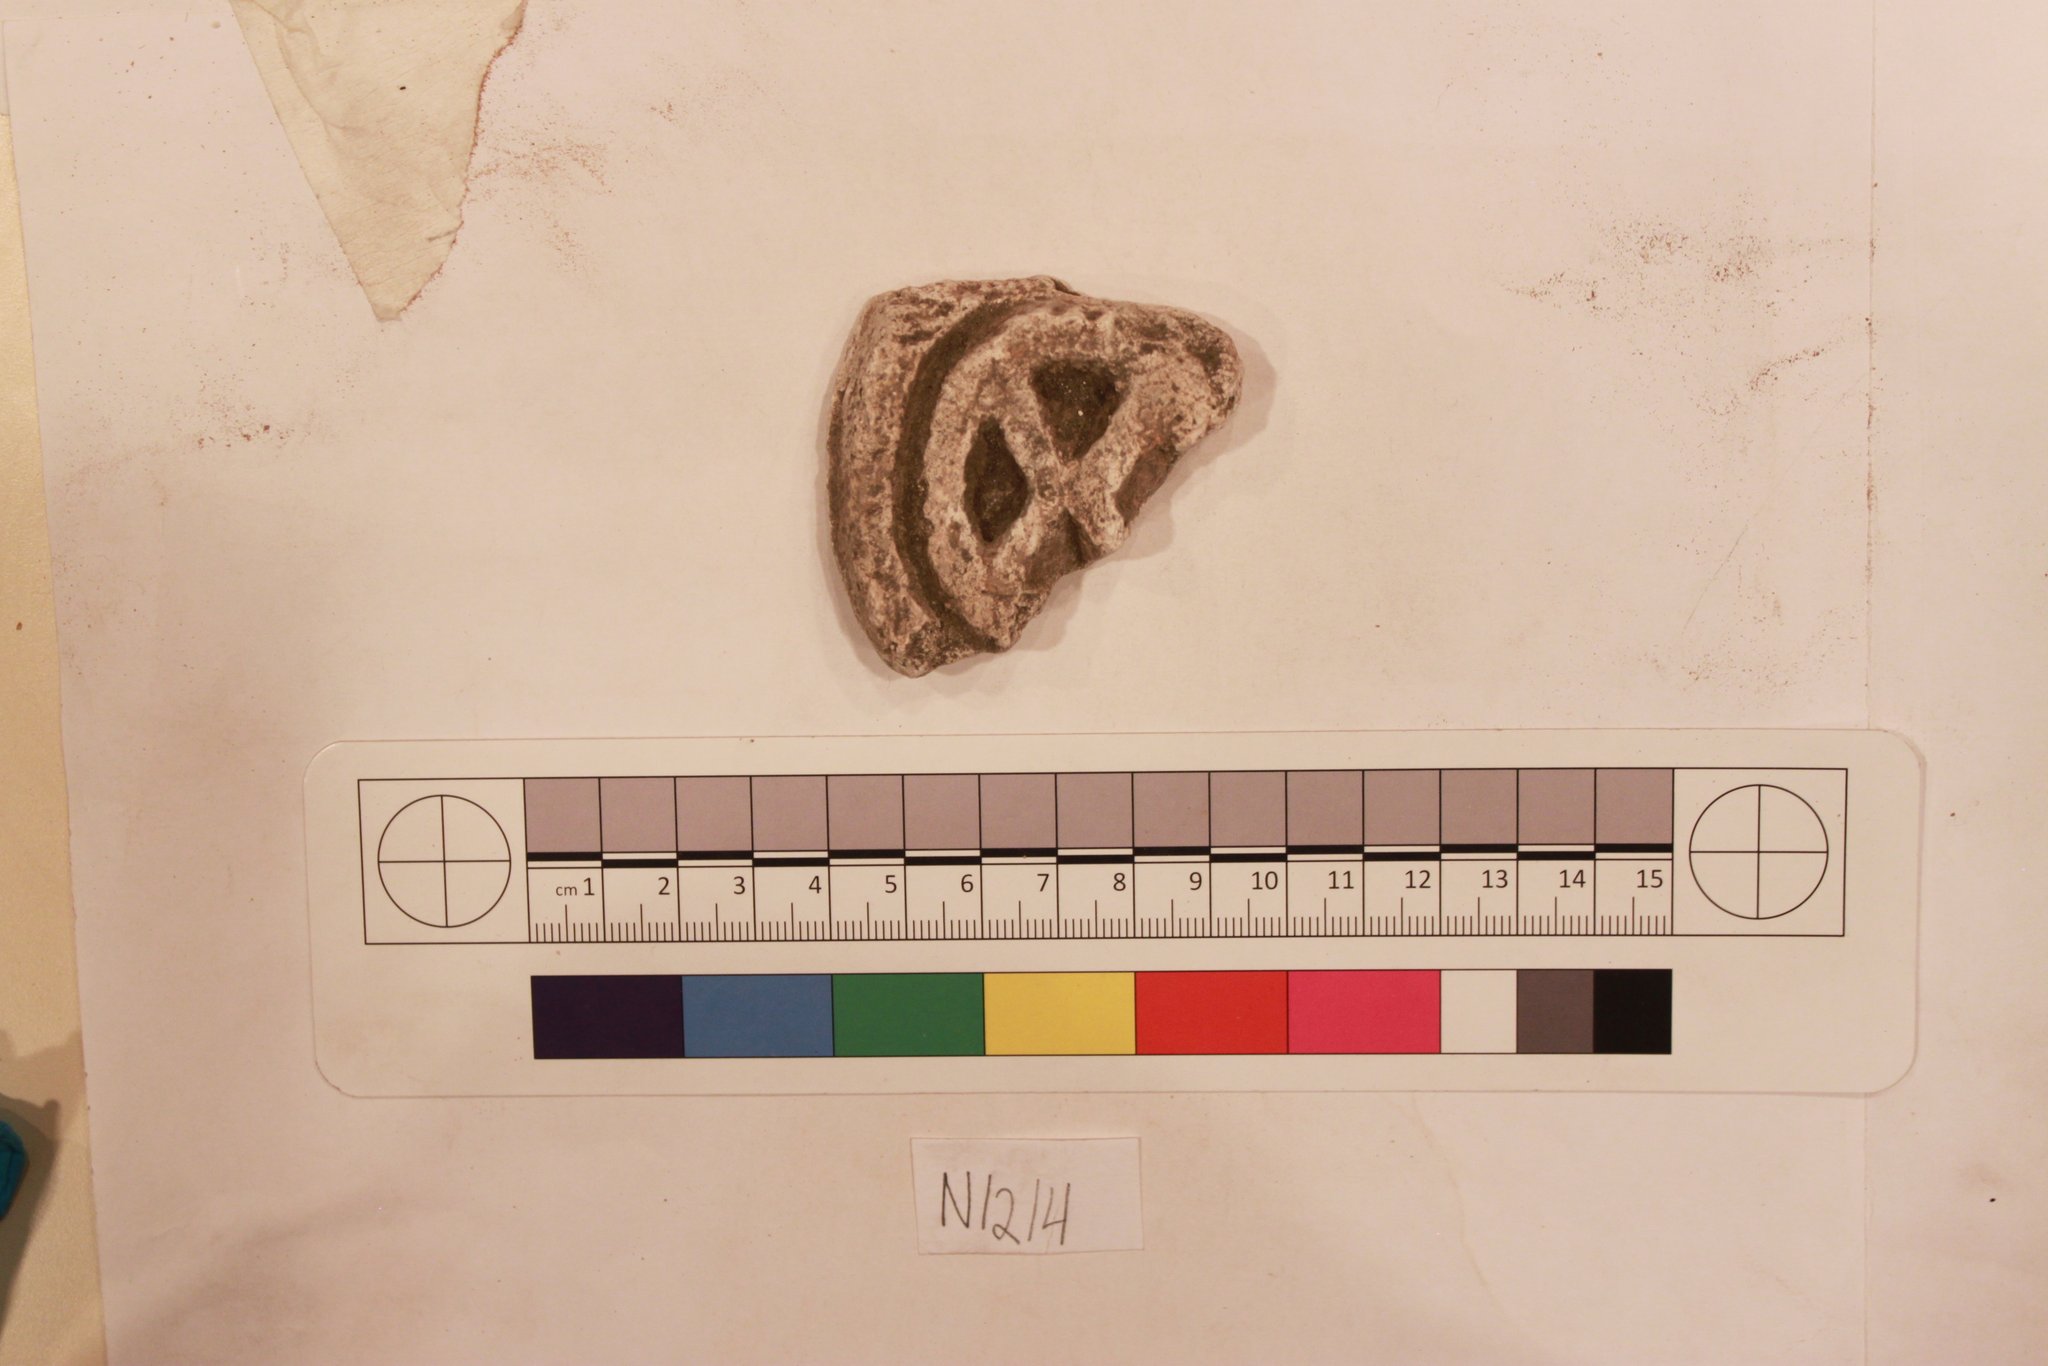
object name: fragment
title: Stucco Fragment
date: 701-1200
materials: plaster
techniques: carving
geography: iran